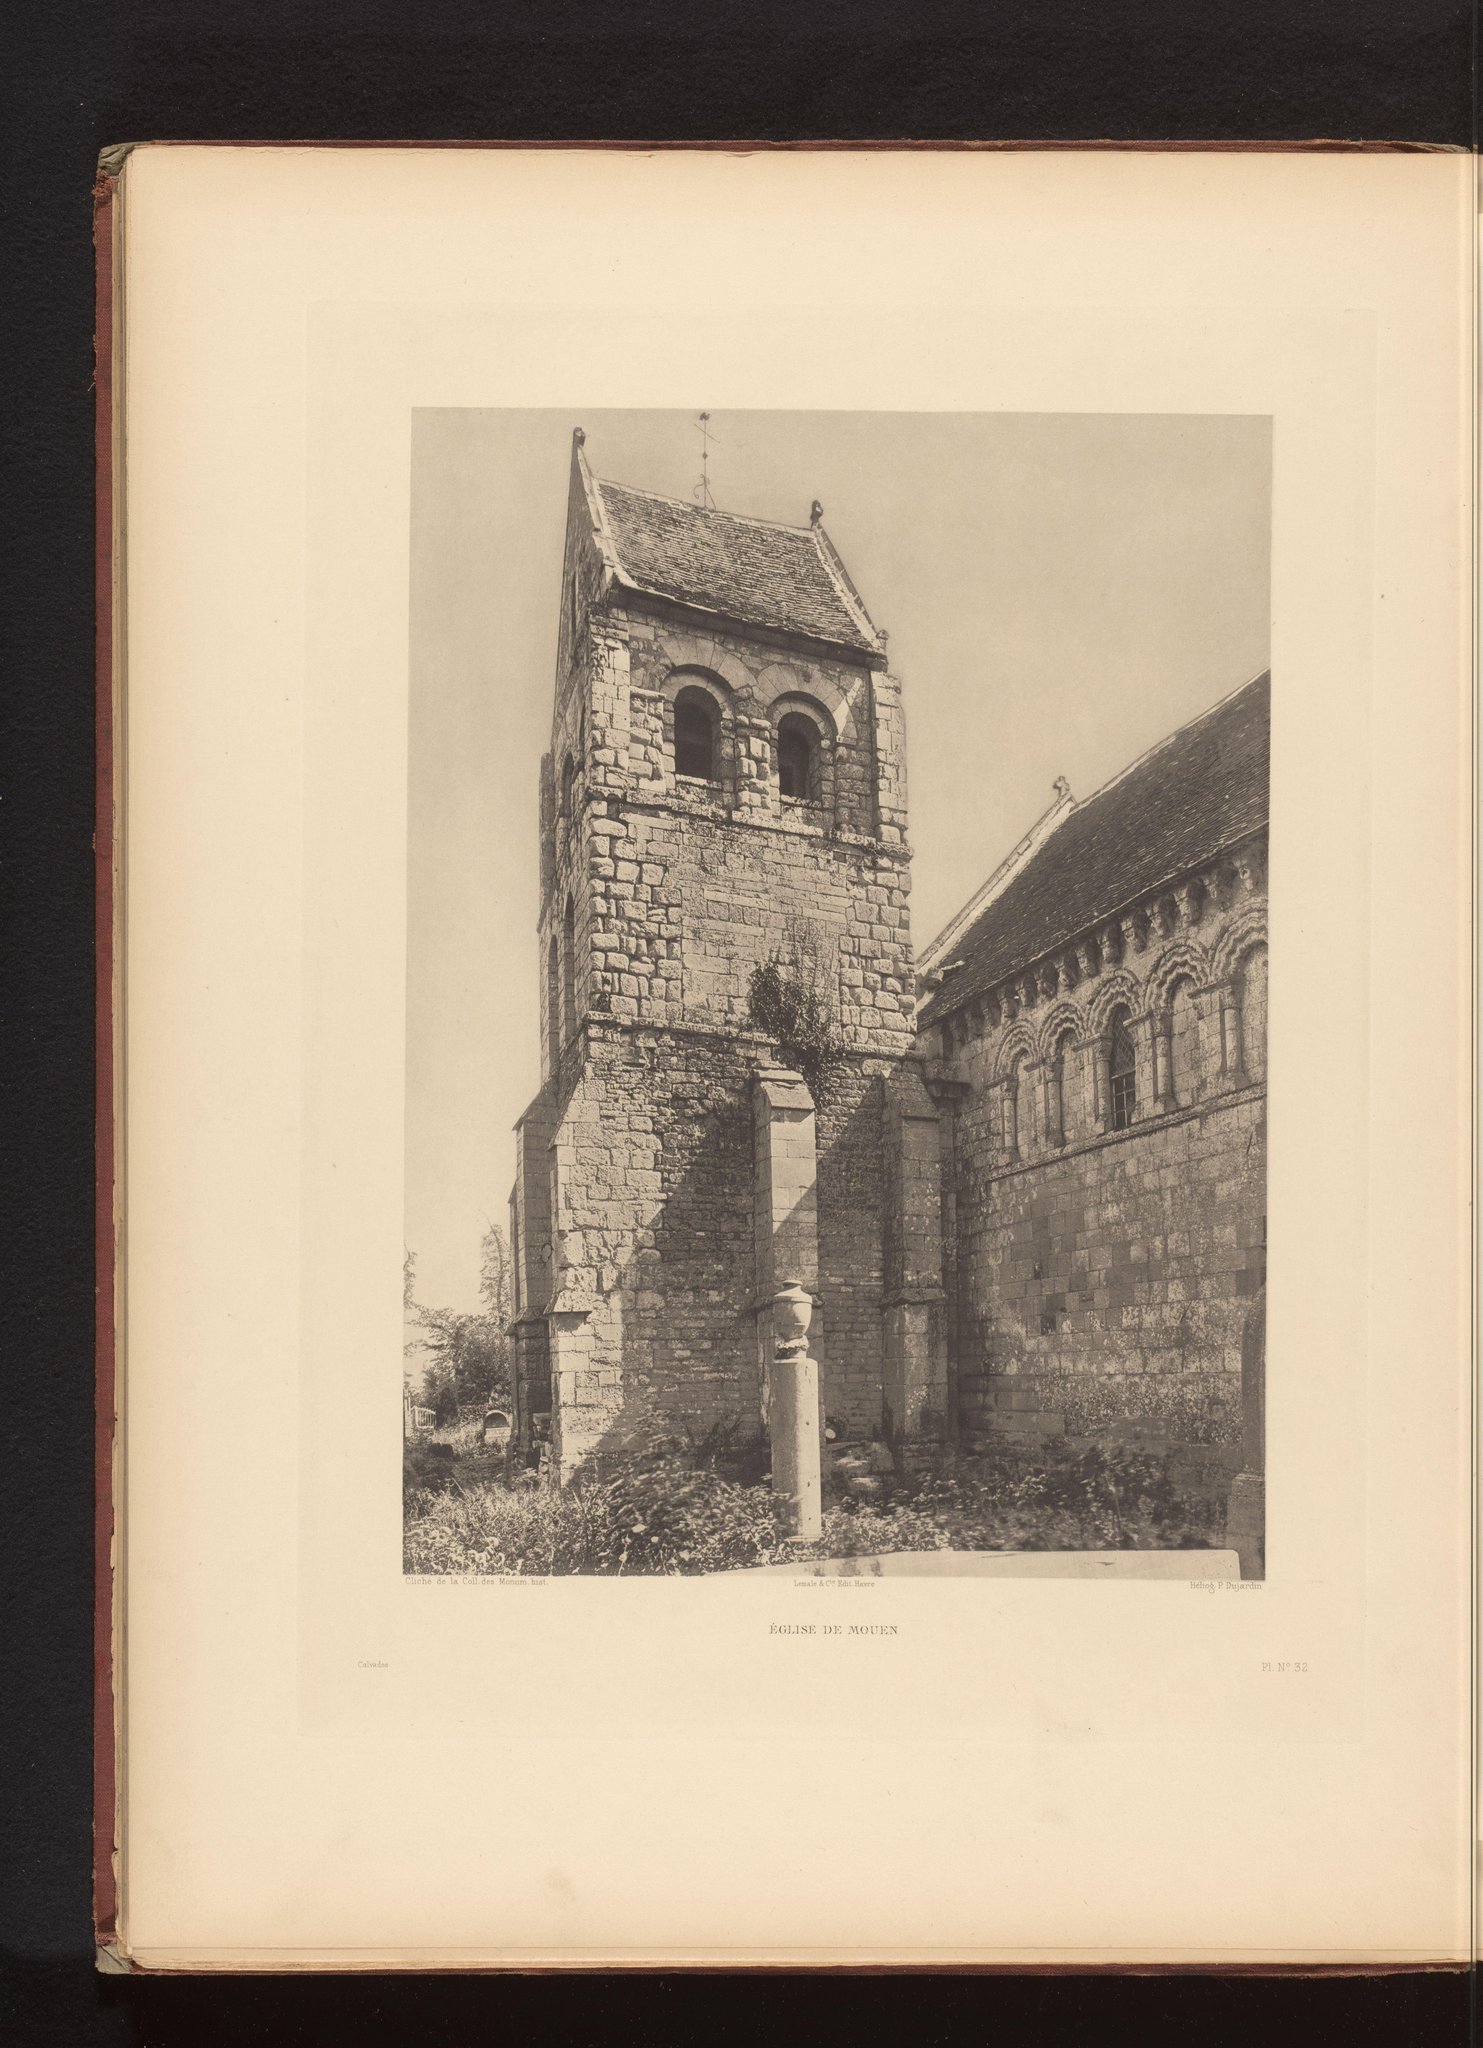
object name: photomechanical print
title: Gezicht op de Église Saint-Malo in Mouen, Normandië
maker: paul dujardin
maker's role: print maker, printer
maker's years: 1843-1913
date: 1890-1895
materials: paper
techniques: photoaquatint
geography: le havre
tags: church (exterior)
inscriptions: number: ‘Pl. No. 32’, inscription: ‘Calvados.’